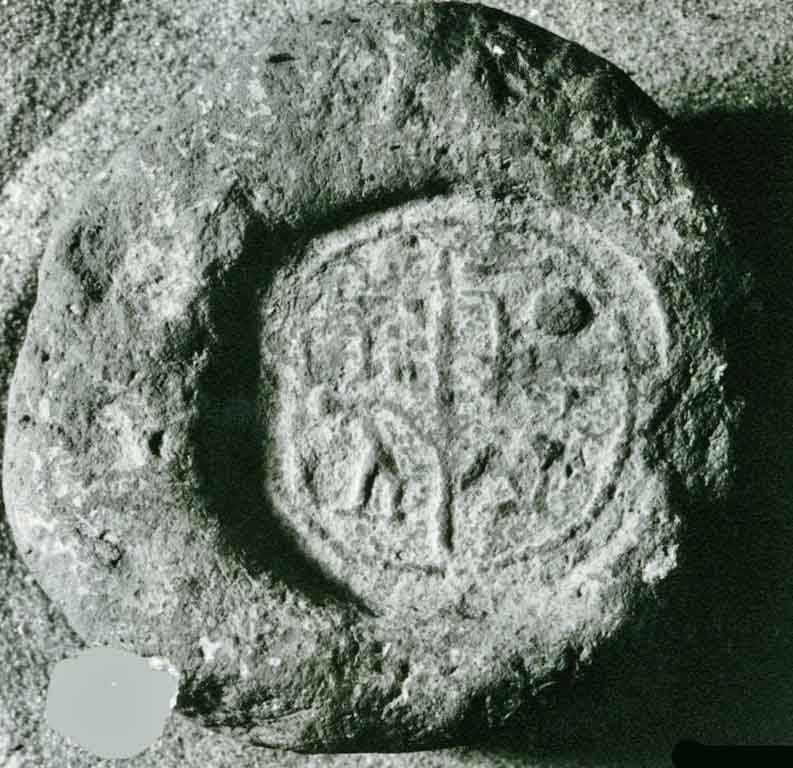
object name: cone, meryre, circular impression, chief steward of the king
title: Funerary Cone of the Chief Steward of the King Meryre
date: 1550-1295 BCE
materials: pottery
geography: egypt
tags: hieroglyphs